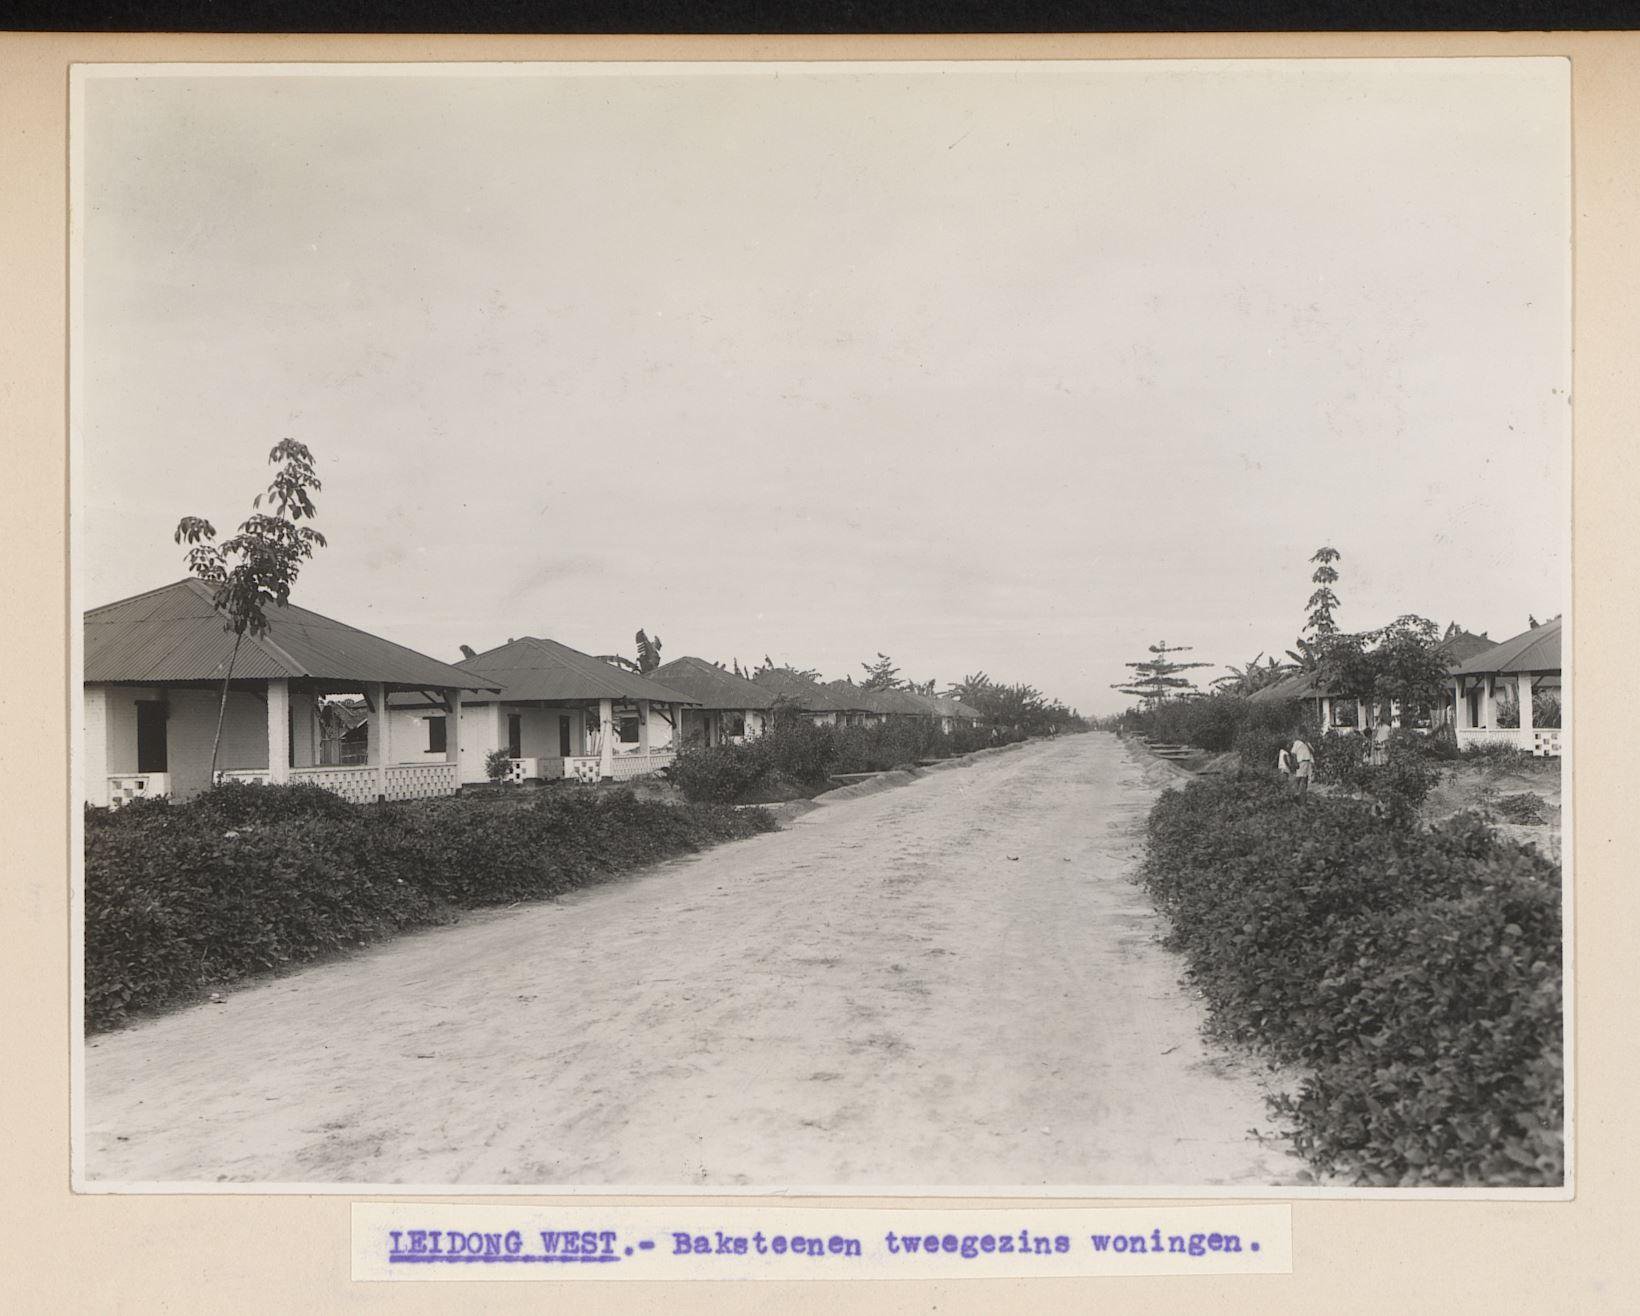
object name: photograph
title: Leidong West - Baksteenen tweegezins woningen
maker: Anonymous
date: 1930-1939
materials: photographic support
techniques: gelatin silver print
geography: sumatra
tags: plantation, (non-fruit) products of plants or trees: rubber, rural housing, e.g. country-house, villa, cottage, sumatra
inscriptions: inscription: ‘Leidong West - Baksteenen tweegezins woningen.’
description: Straat met aan weerszijden tweegezinswoningen. Onderdeel van het fotoalbum over de plantages Leidong West en Kanopan Oeloe van de Cultuur Maatschappij Leidong West op Sumatra in de jaren 1925-1939.